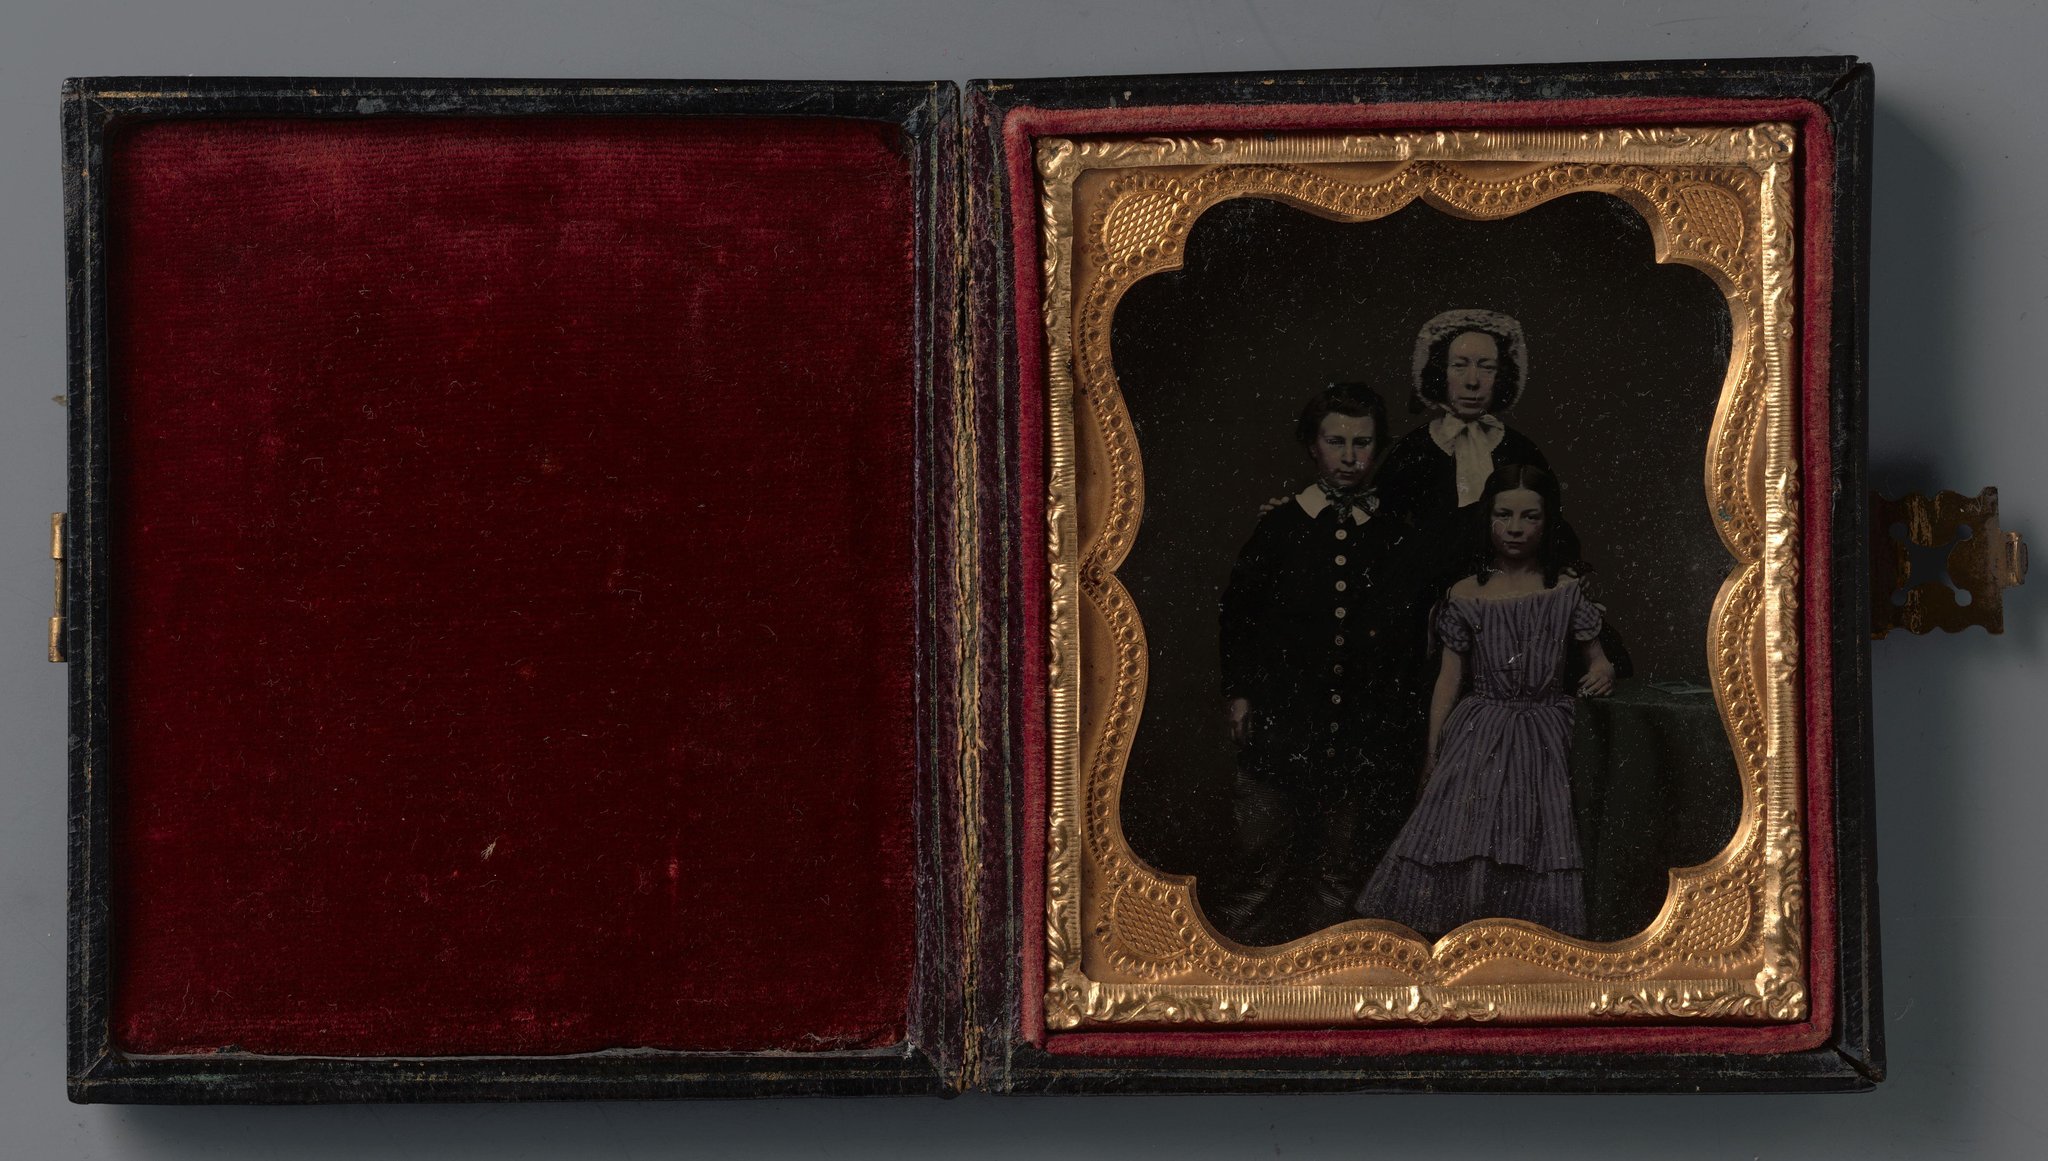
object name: photograph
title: Portret van een onbekende vrouw en twee onbekende kinderen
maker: Anonymous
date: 1855-1870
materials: glass, metal, velvet, wood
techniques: ambrotype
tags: historical persons - bb - woman, child (+ two persons), mother and baby or young child